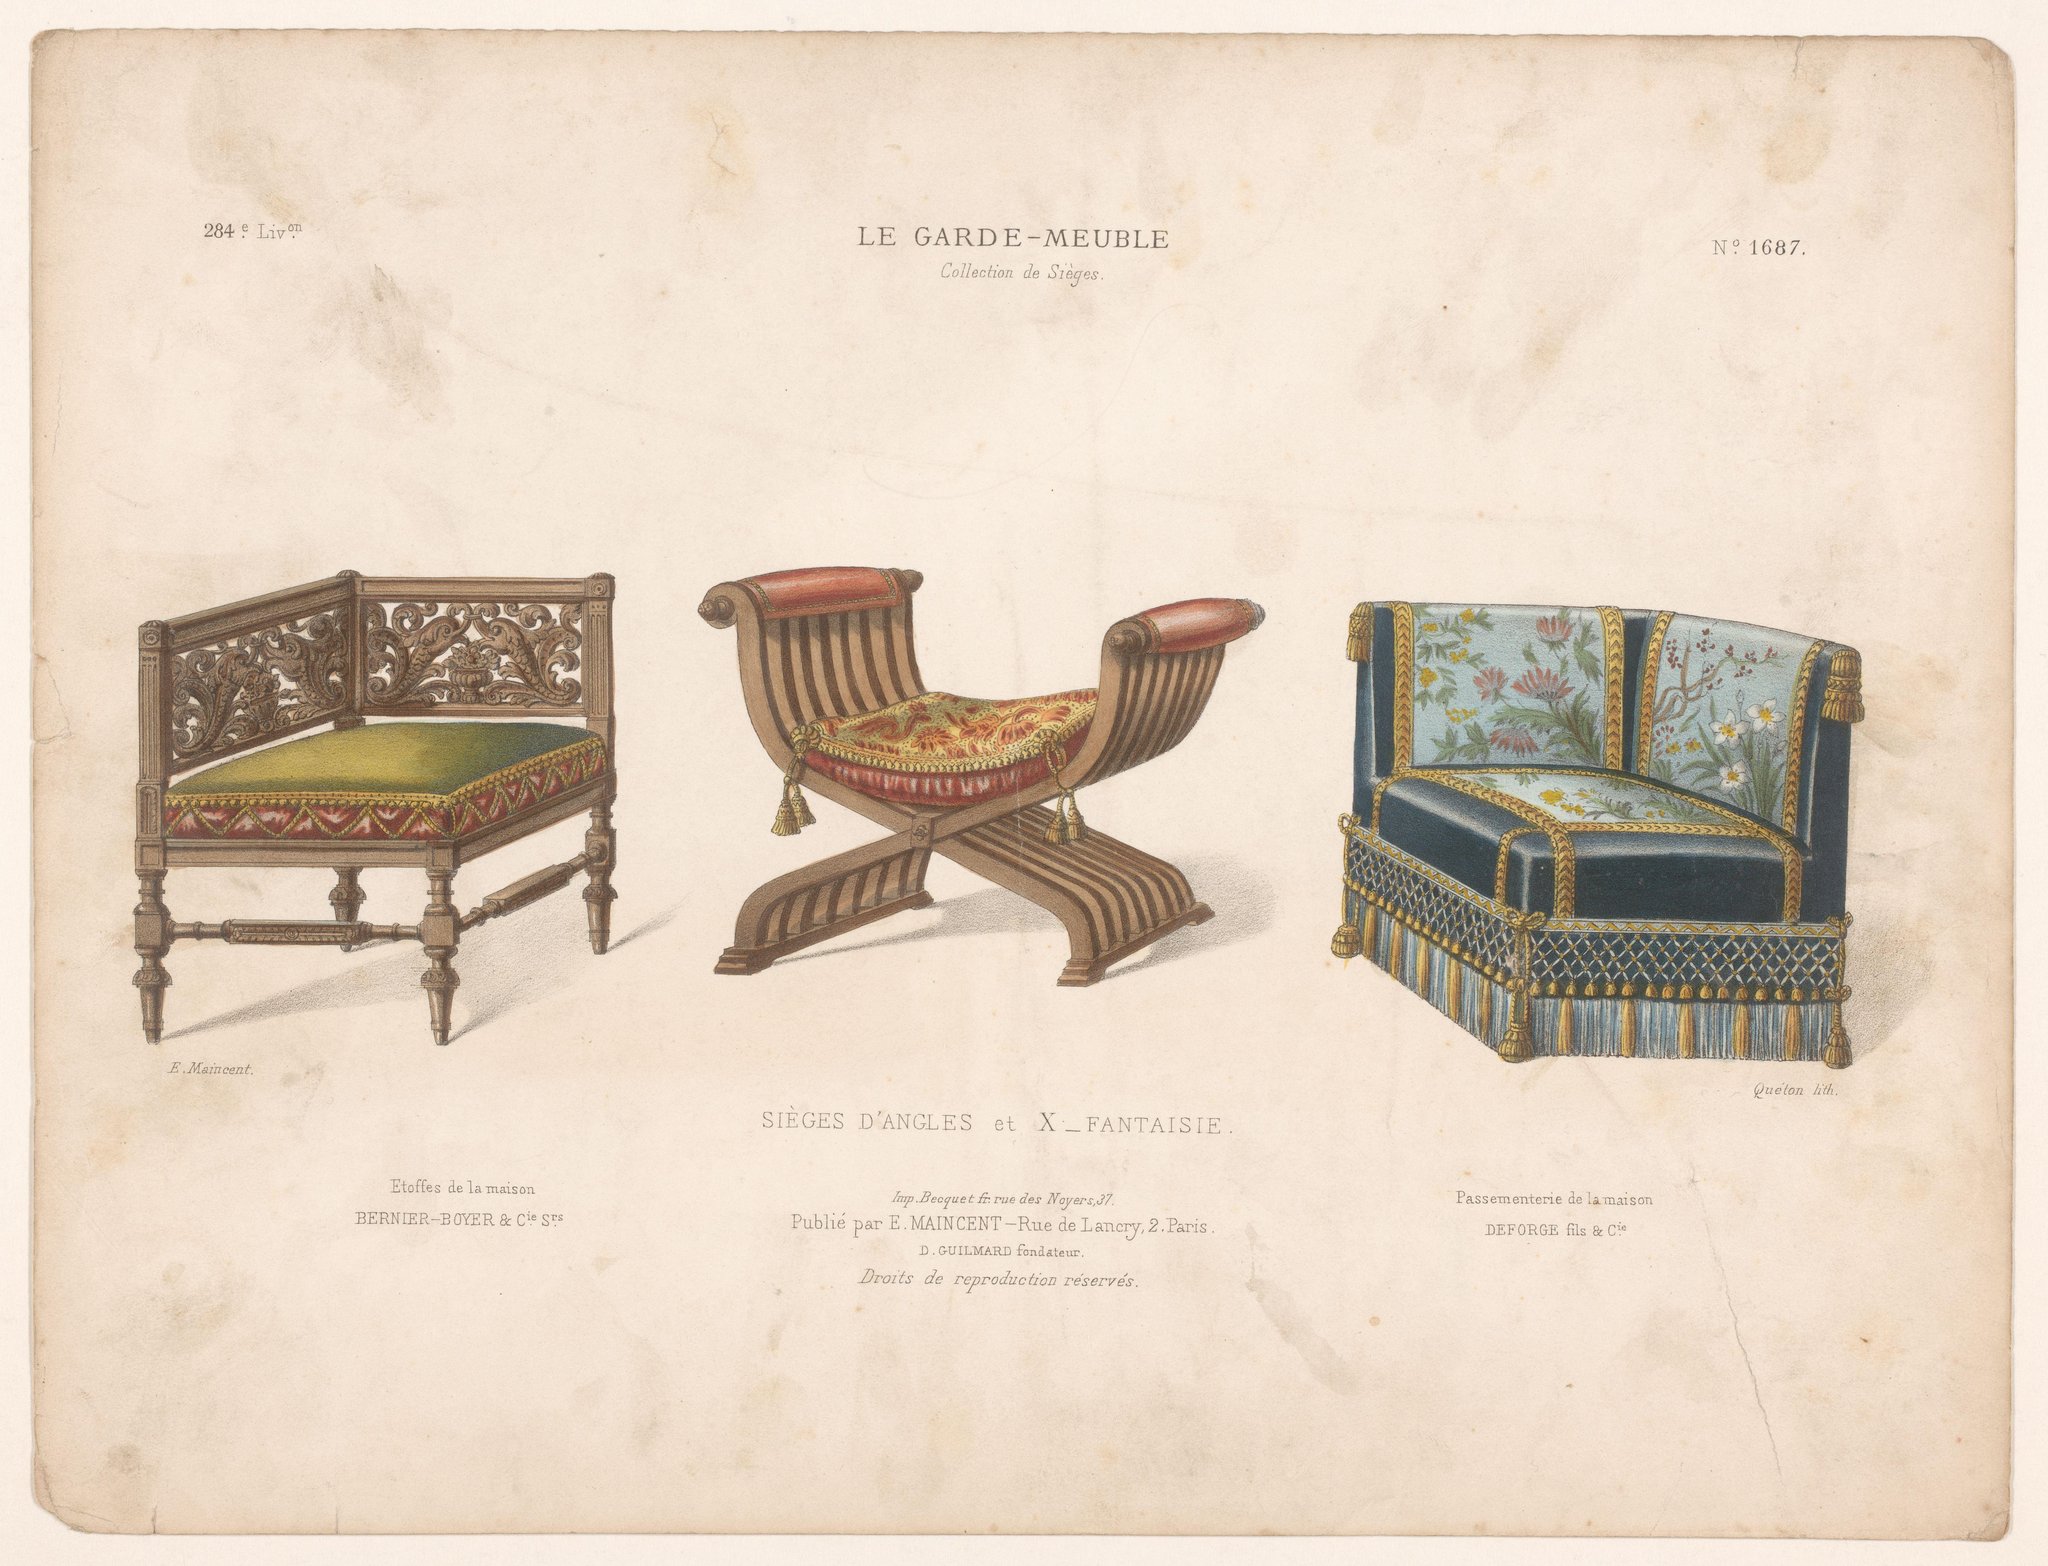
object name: print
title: Sièges d'angles et X fantaisie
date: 1885-1895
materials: paper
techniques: hand coloring, lithograph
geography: paris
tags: seating furniture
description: Ieder Livraison in de serie Le Garde-Meuble bevat negen platen: drie 'sièges' (zitmeubels), drie 'meubles' (diverse meubels zoals tafels en kasten) en drie 'tentures' (gordijnen en draperieën).